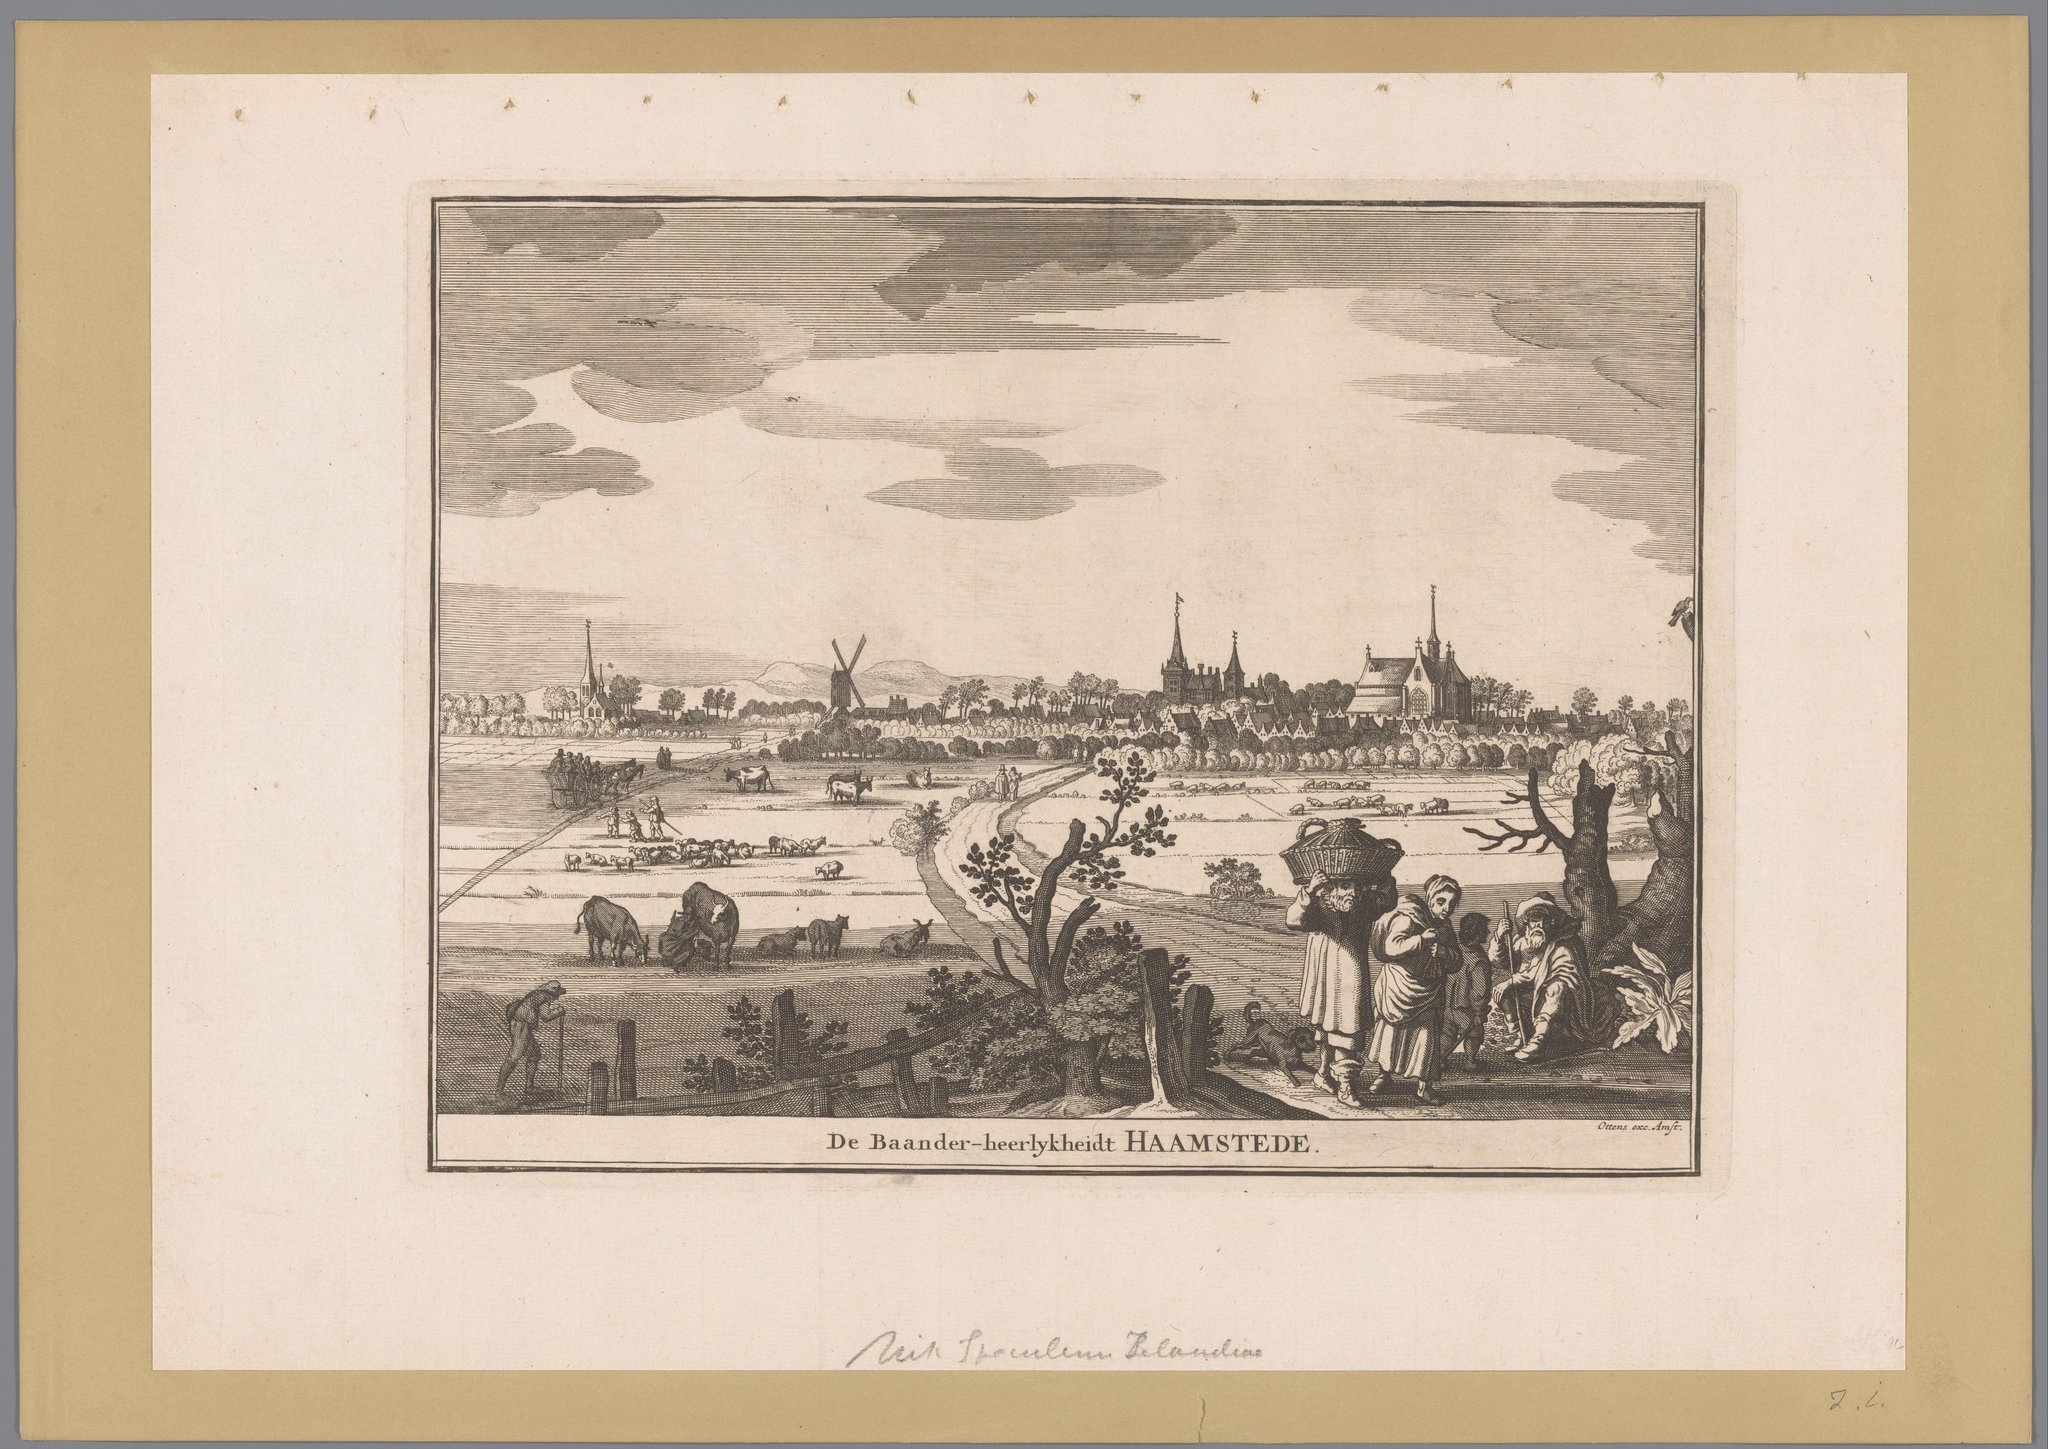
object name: print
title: De Baander-heerlykheidt Haamstede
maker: pieter hendricksz. schut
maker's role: print maker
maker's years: 1618-1660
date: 1719-1725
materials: paper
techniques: engraving, etching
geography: amsterdam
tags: city-view, and landscape with man-made constructions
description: Prent uit: Speculum Zelandiae dat is een beschryvinge ofte afbeelding der steden, ambachts-heerlijckheden, dorpen castelen, ridderlijcke hofsteden, huysen en gebouwen gelegen inde eylanden en de graeflijckheyt van Zeelandt. Amsterdam: weduwe Ottens en Zoonen, [1719-1725]. De eerste publicatie waarin de eerste staat van de prent linksonder voorkomt dateert uit 1656. De eerste publicatie waarin de eerste staat van de andere drie prenten voorkomt dateert uit 1657.